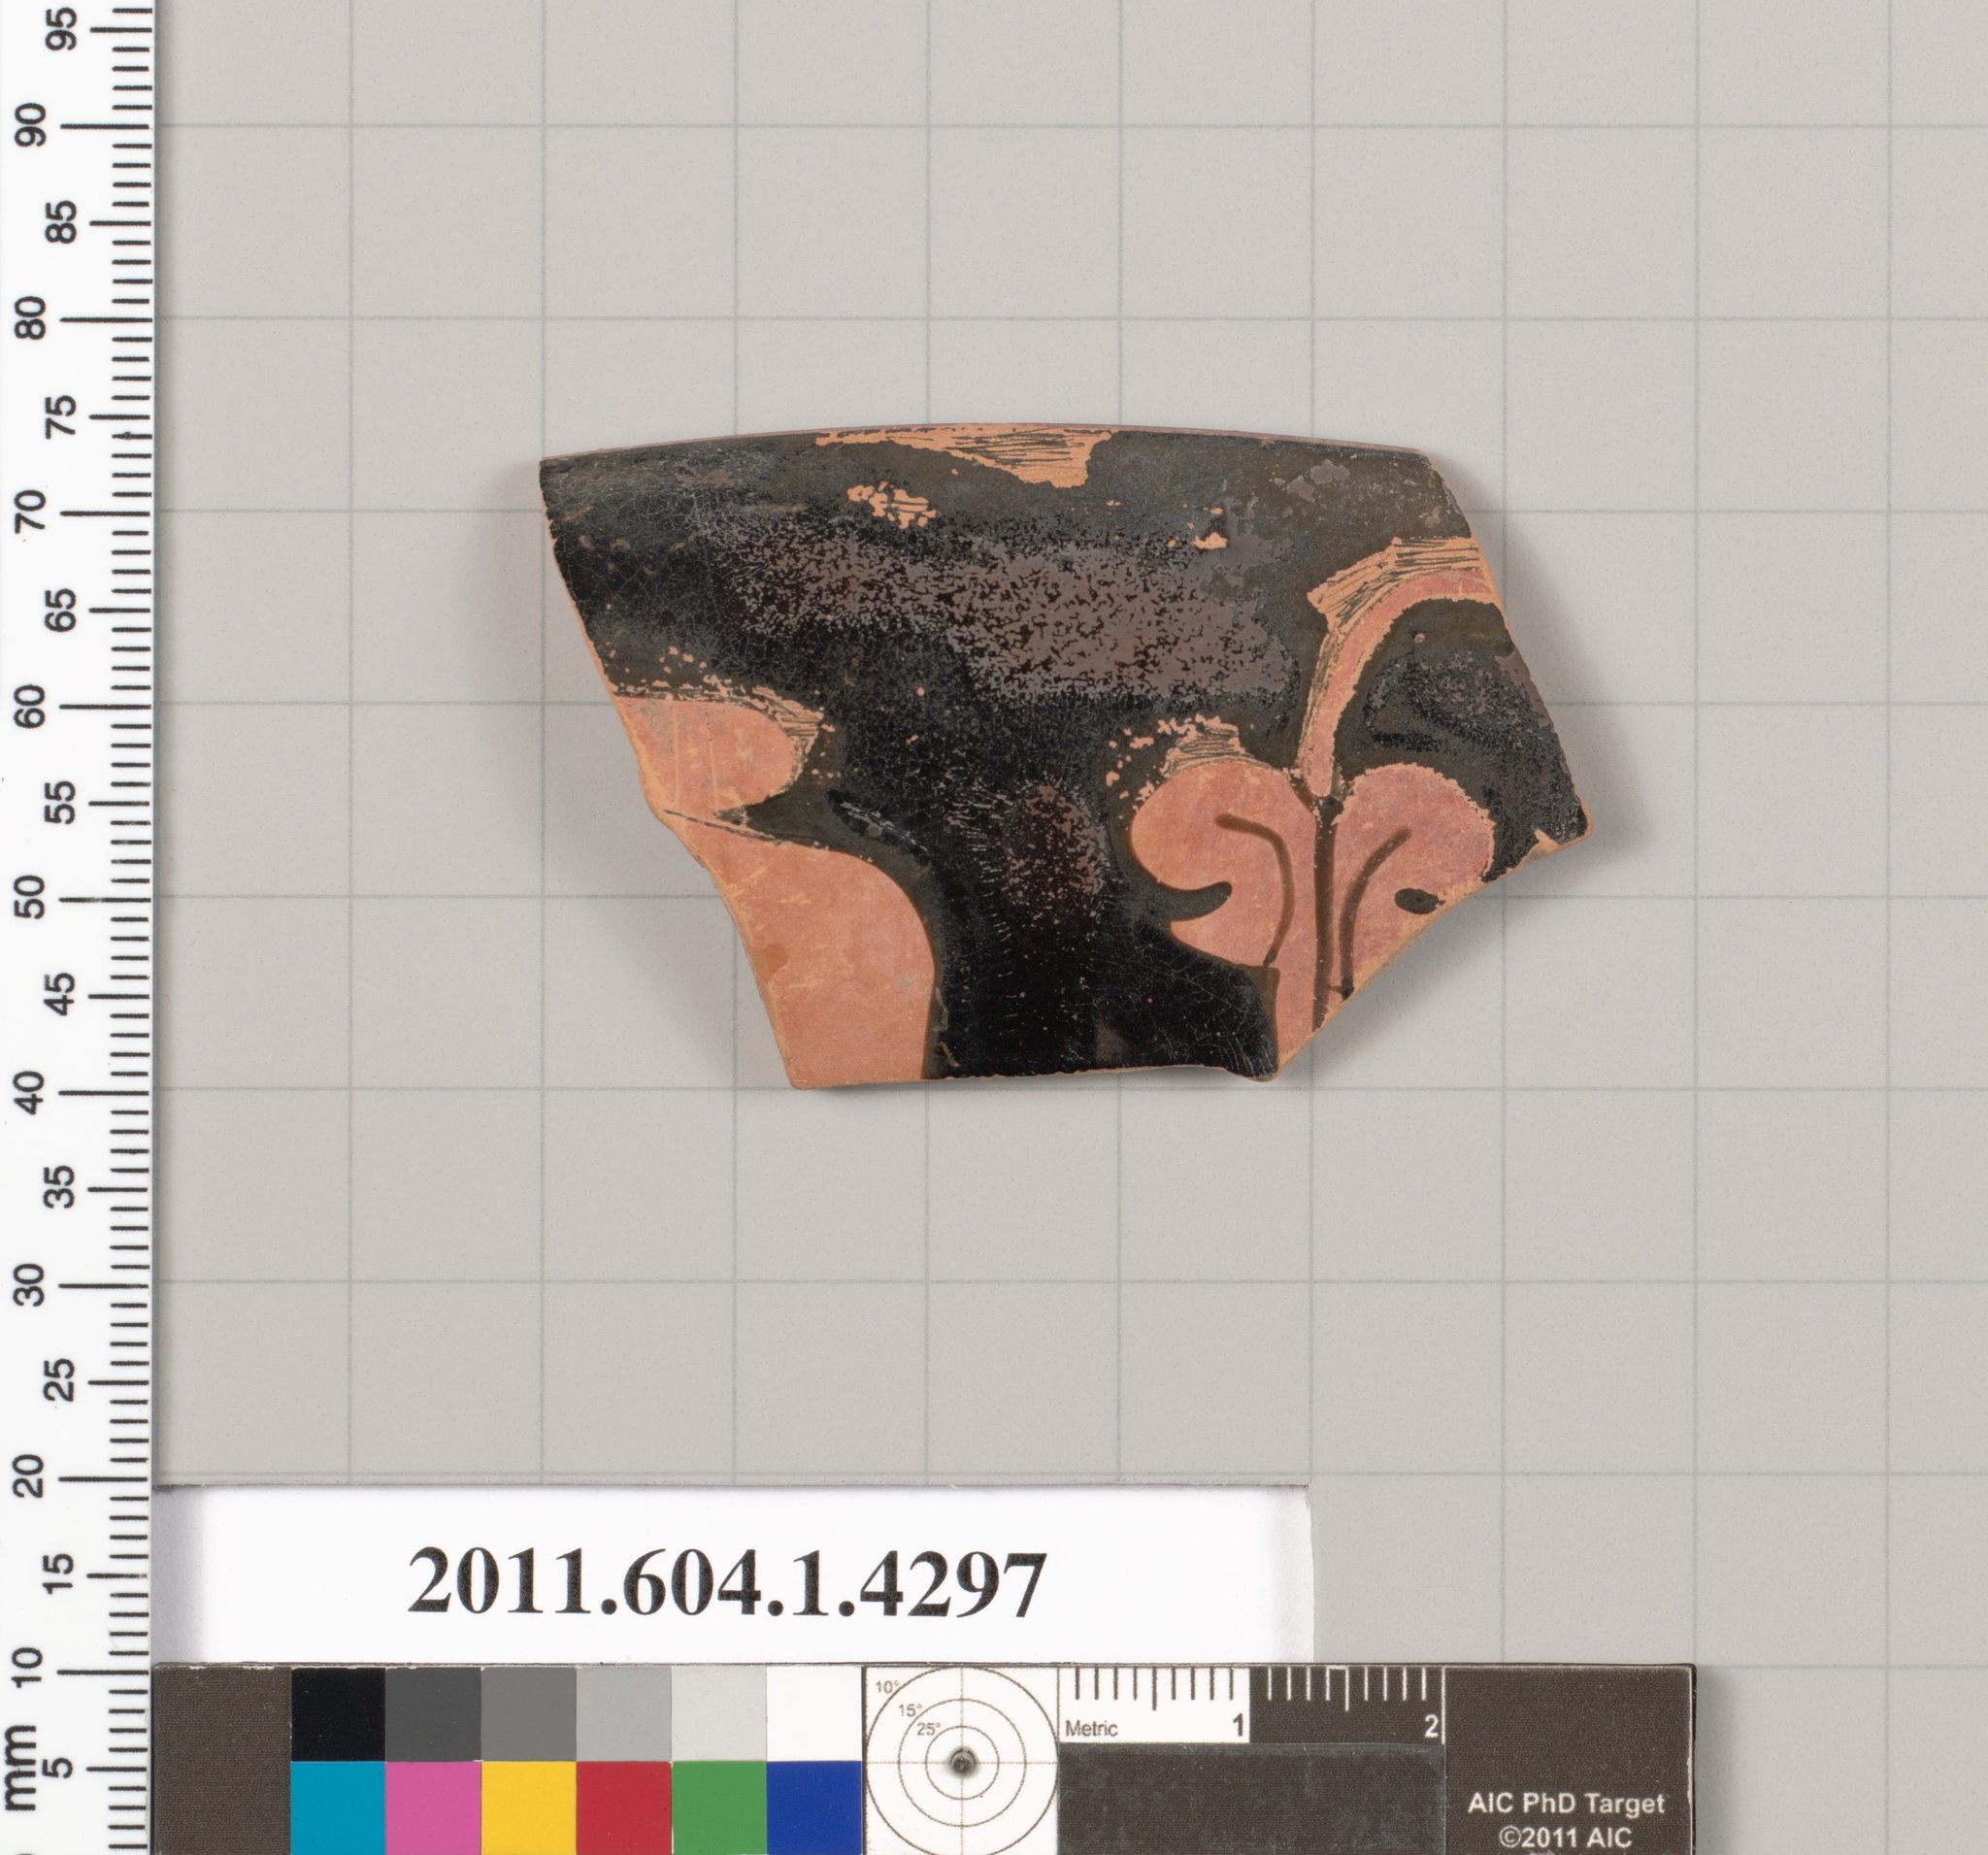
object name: kylix fragment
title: Terracotta rim fragment of a kylix (drinking cup)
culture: greek, attic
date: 470-440 BCE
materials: terracotta